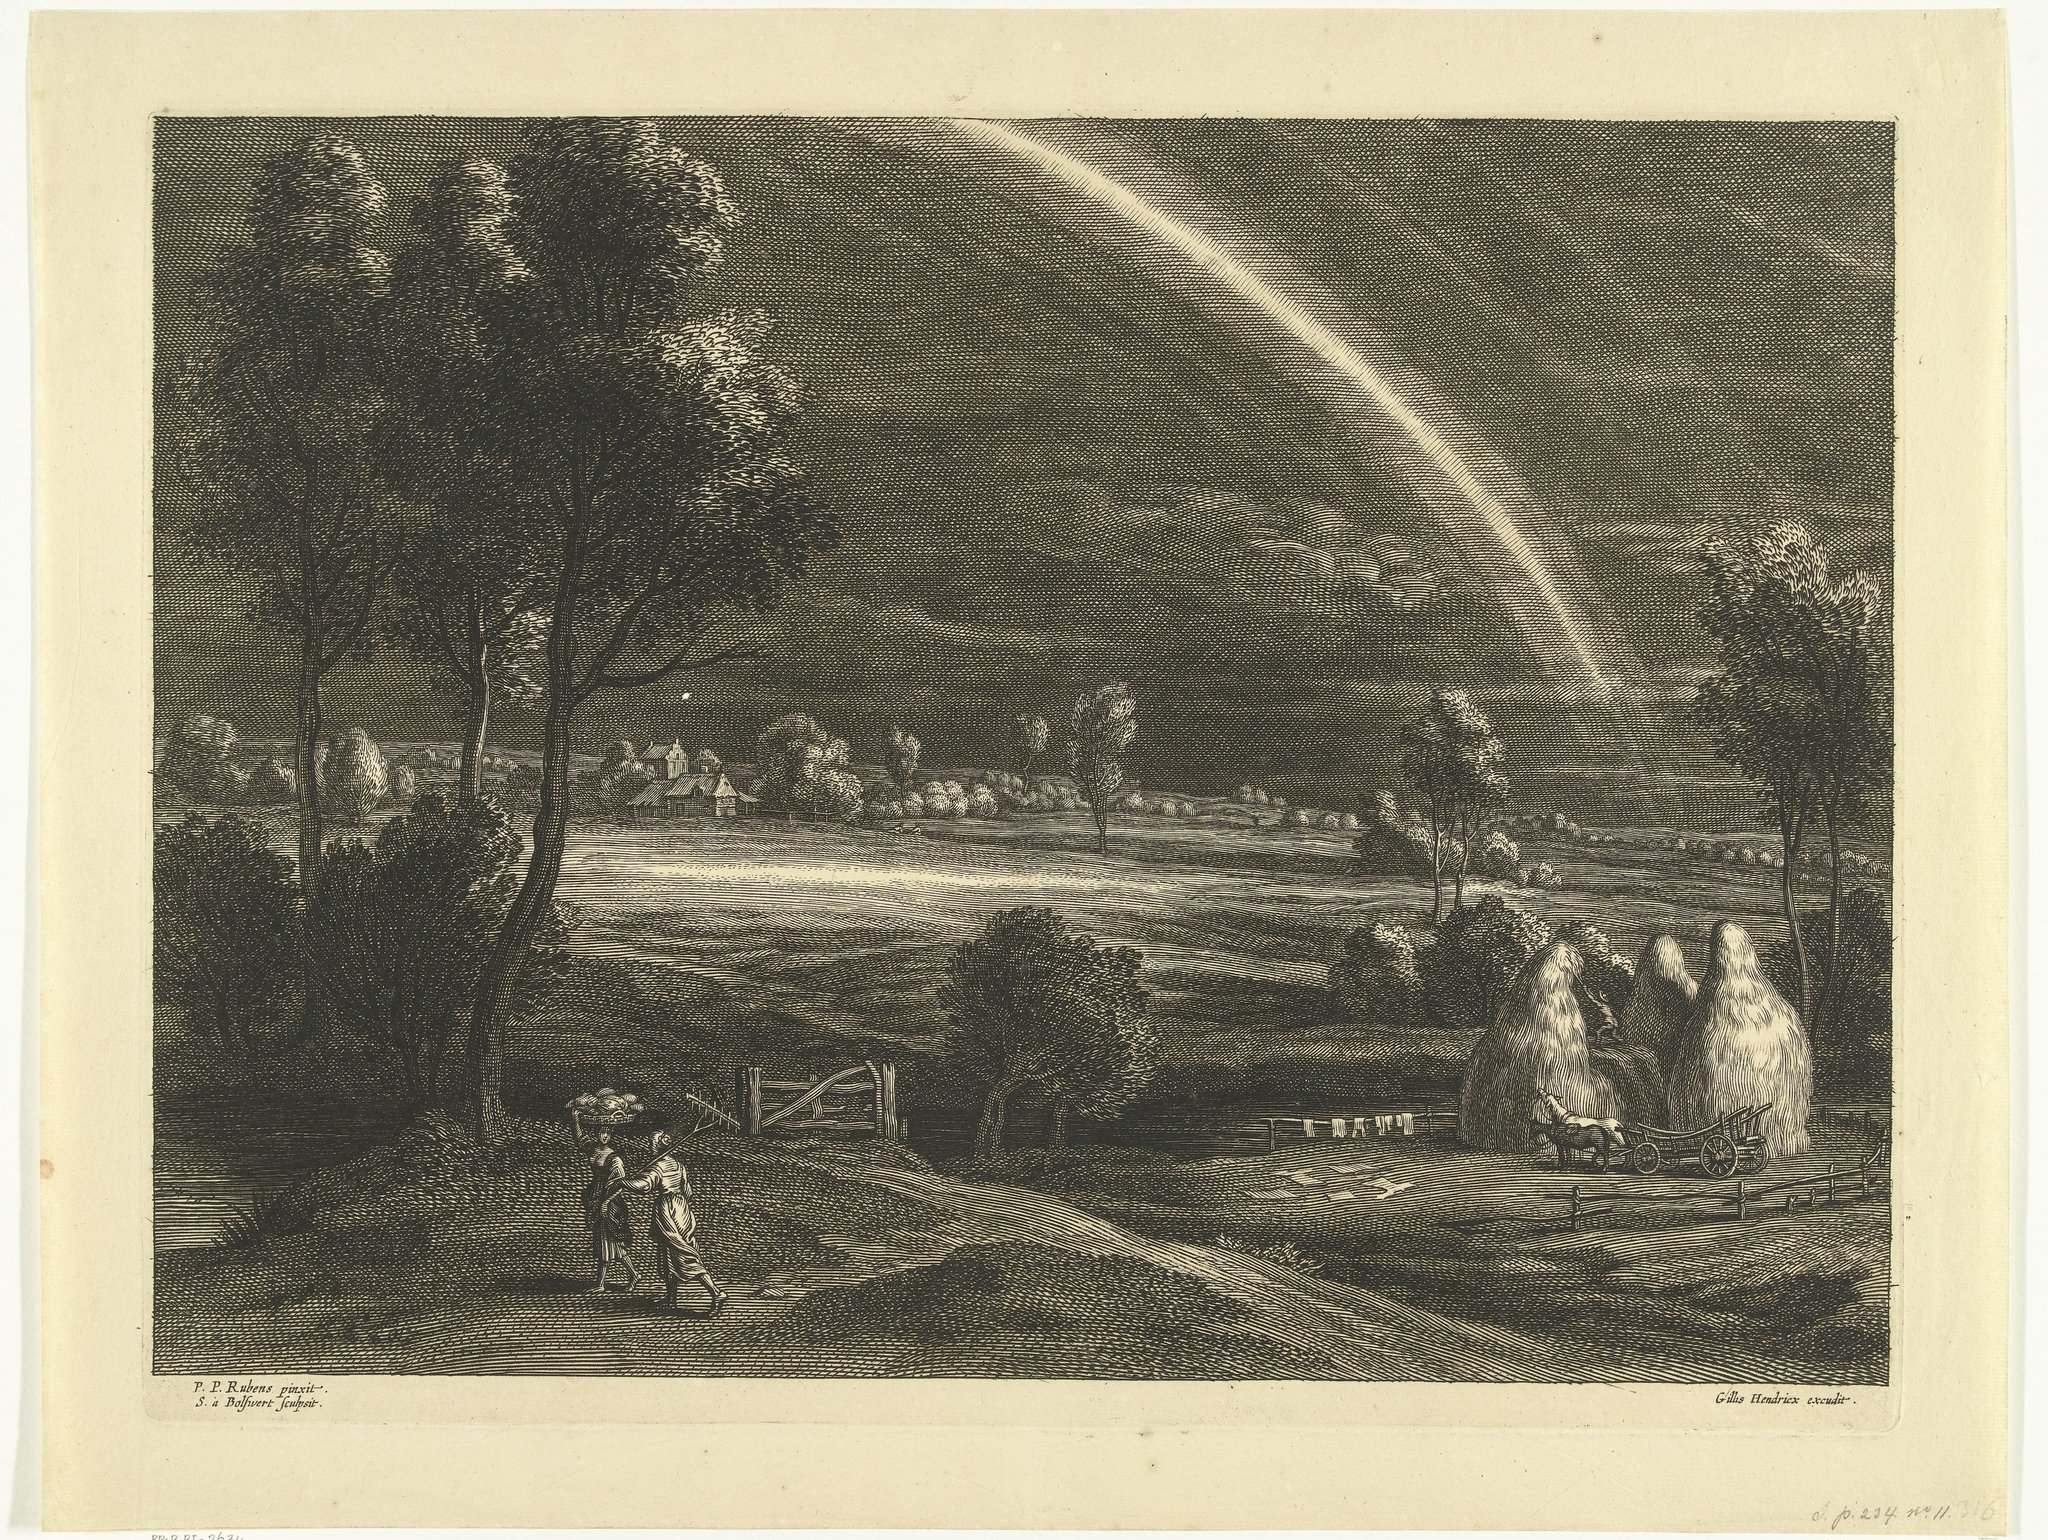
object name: print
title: Landschap met regenboog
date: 1596-1659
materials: paper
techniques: engraving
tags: full moon, meadow, pasture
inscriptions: collector's mark: Lugt 240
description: Prent naar schilderij van Peter Paul Rubens. Hollstein beschrijft een serie kleine landschappen onder de nrs. 305 t/m 325 maar deze prenten zijn niet als reeks vervaardigd.